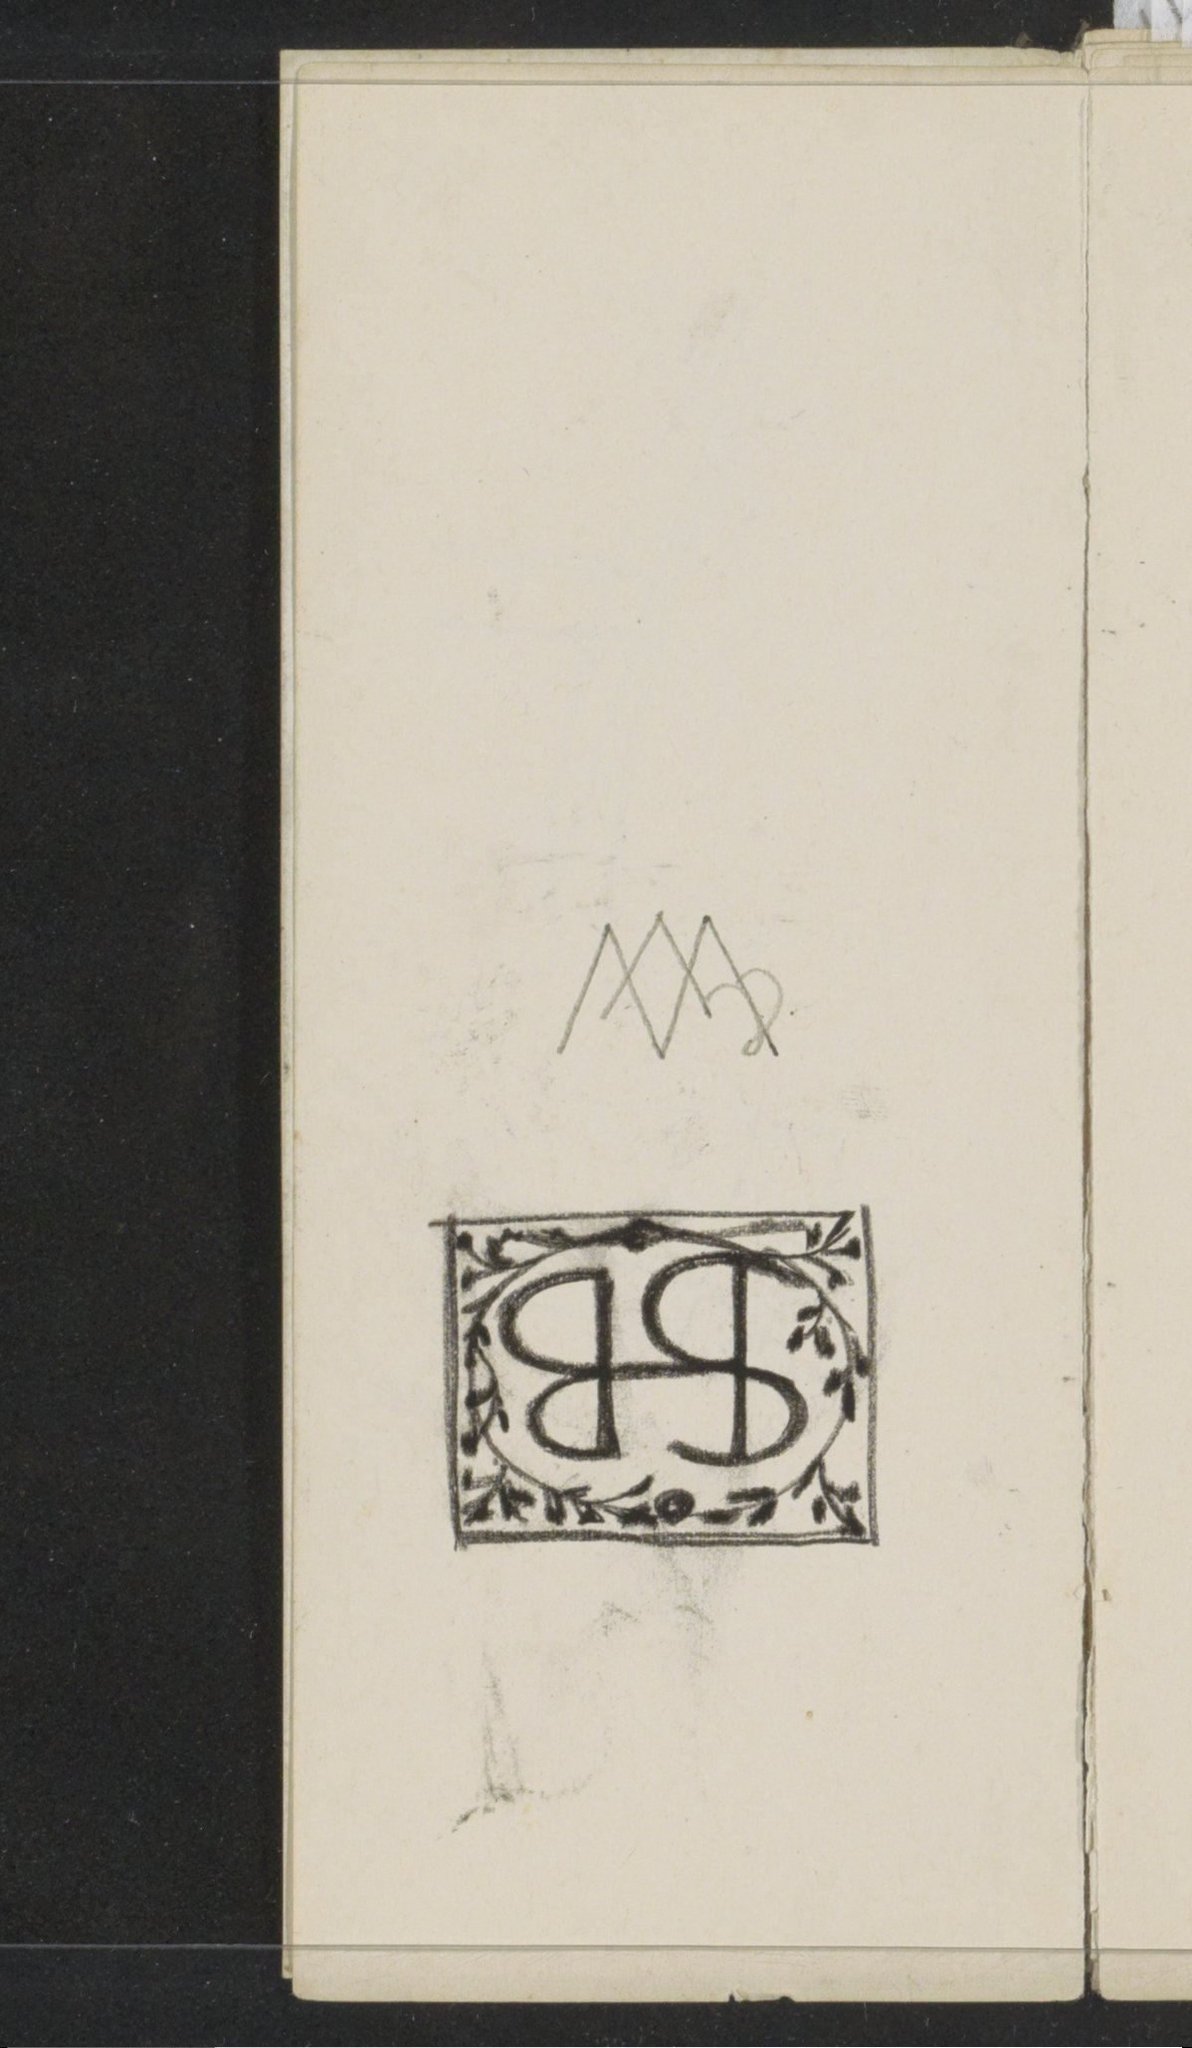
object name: sketchbook leaf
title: Ontwerpen voor twee monogrammen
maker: gerrit willem dijsselhof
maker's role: designer, draughtsman, print maker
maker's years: 1866-1924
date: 1901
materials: chalk, paper, pencil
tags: letter combinations such as letterword, anagram, letter square, monogram, etc.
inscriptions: annotation: ‘SB/ WW’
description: Eén van de monogrammen is omlijst door bladeren. Blad 1 verso uit een schetsboek met 42 bladzijden.